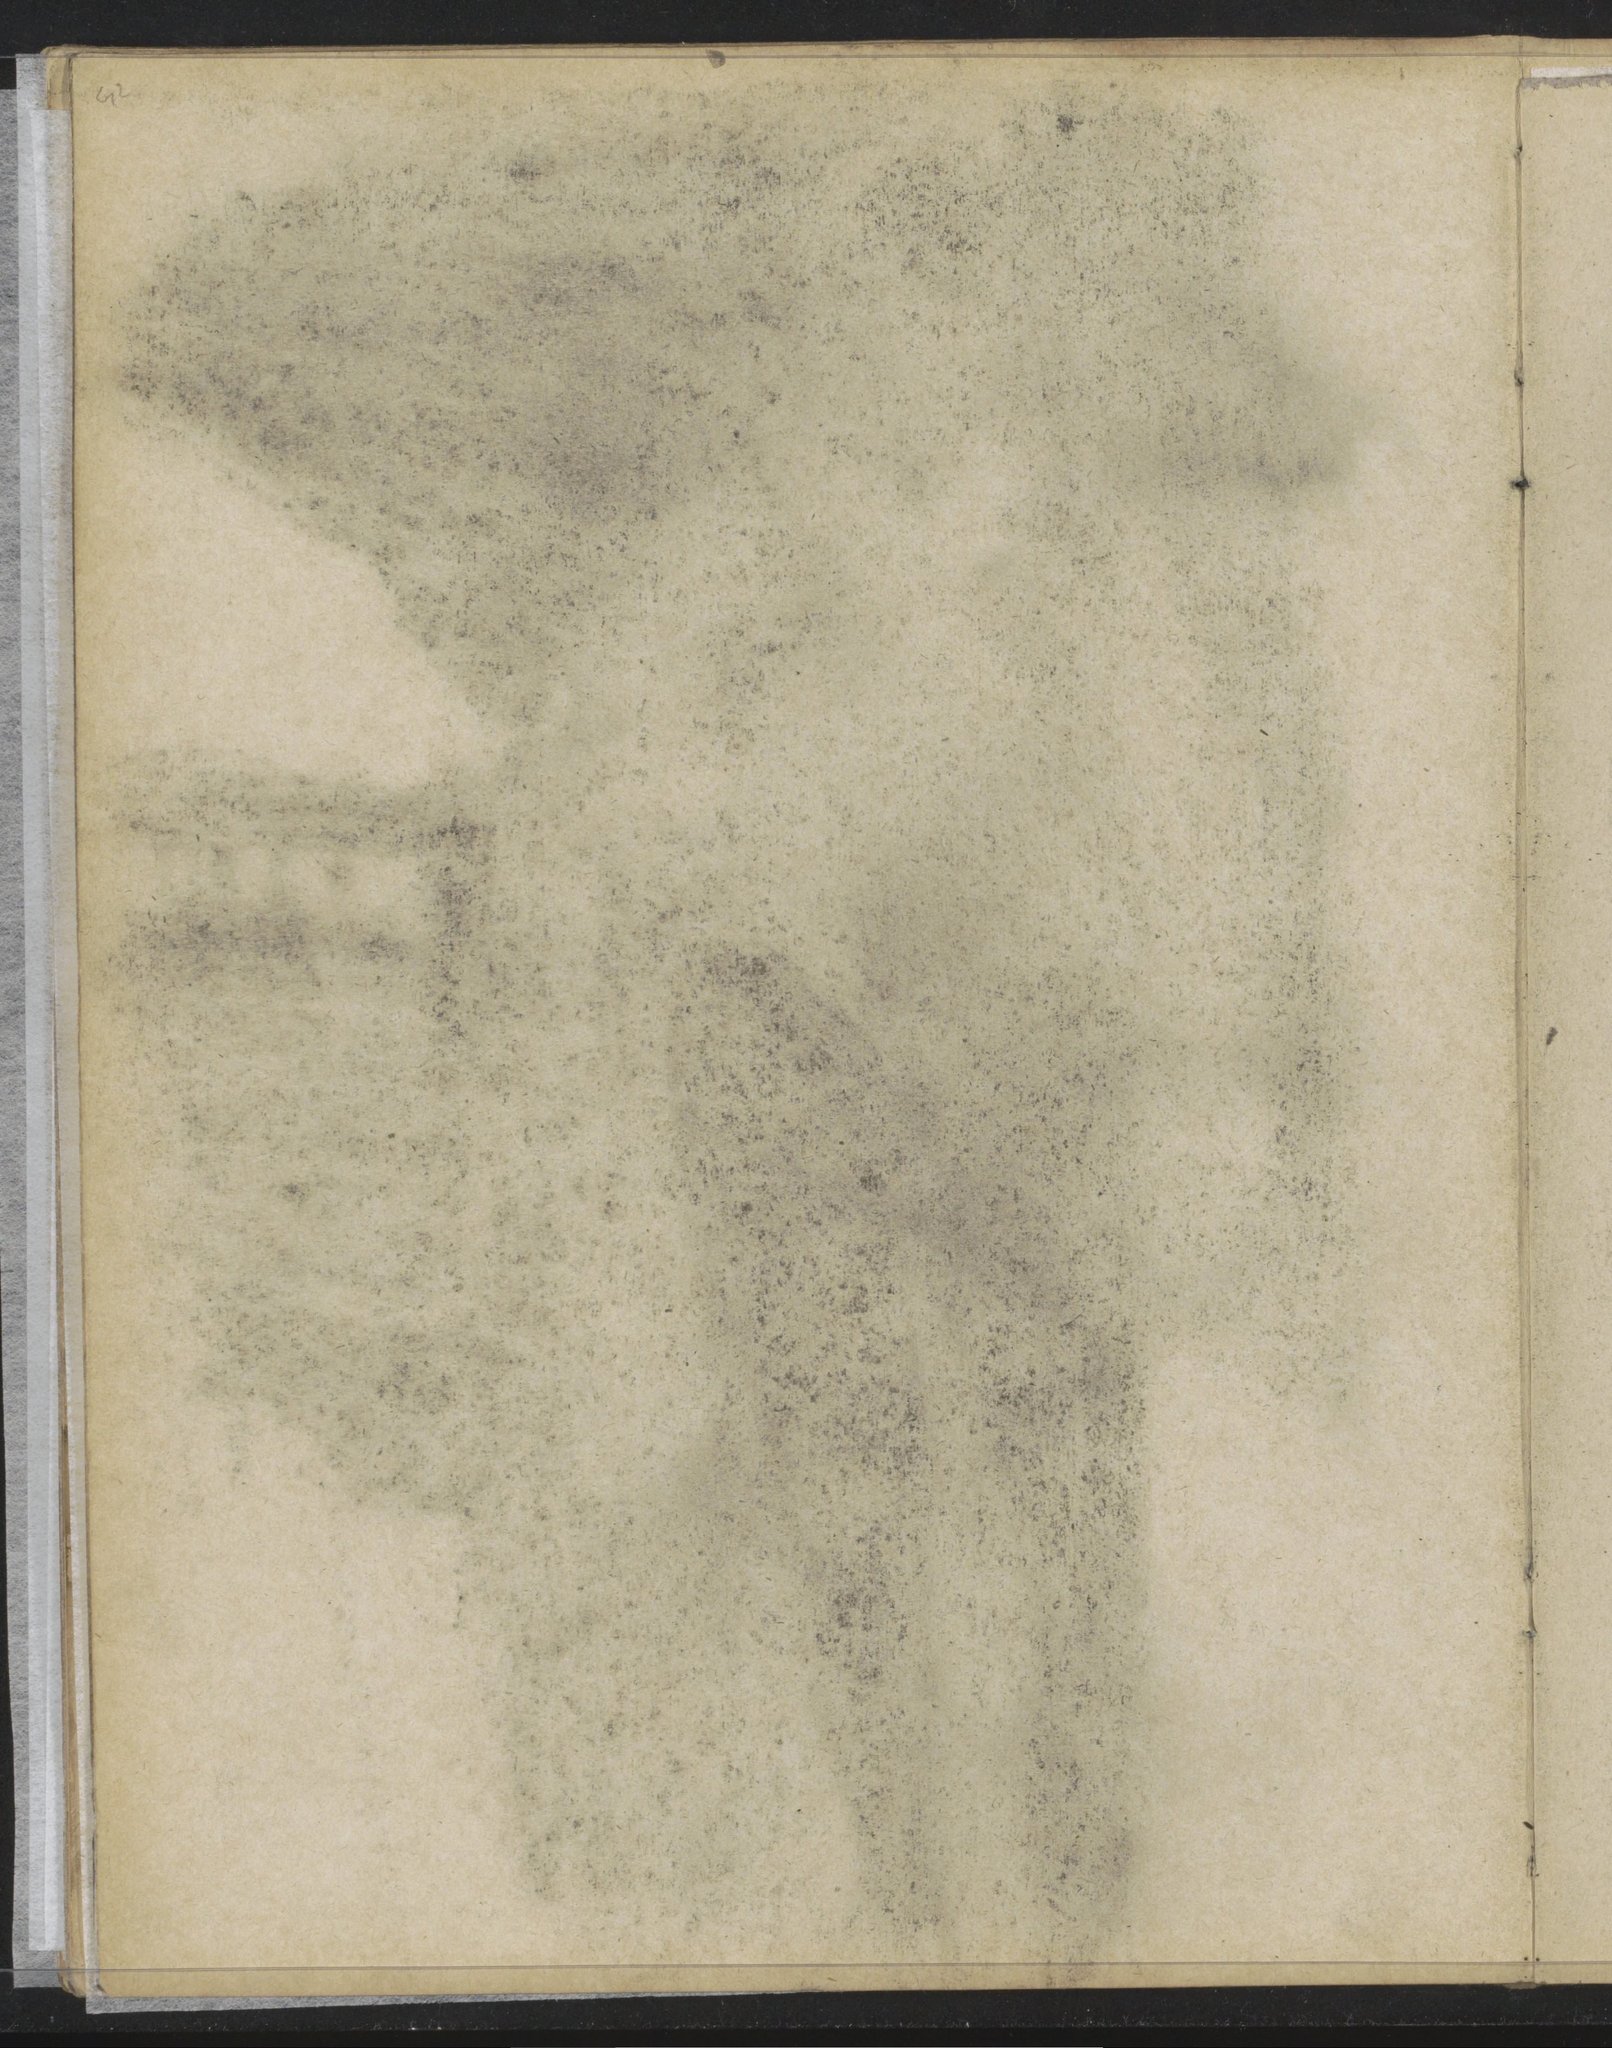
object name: sketchbook leaf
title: Abklatsch van de krijttekening op pagina 43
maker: willem witsen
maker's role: draughtsman, painter, print maker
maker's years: 1860-1923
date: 1886-1891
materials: paper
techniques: printmaking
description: Pagina 42 uit een schetsboek met 40 bladen.